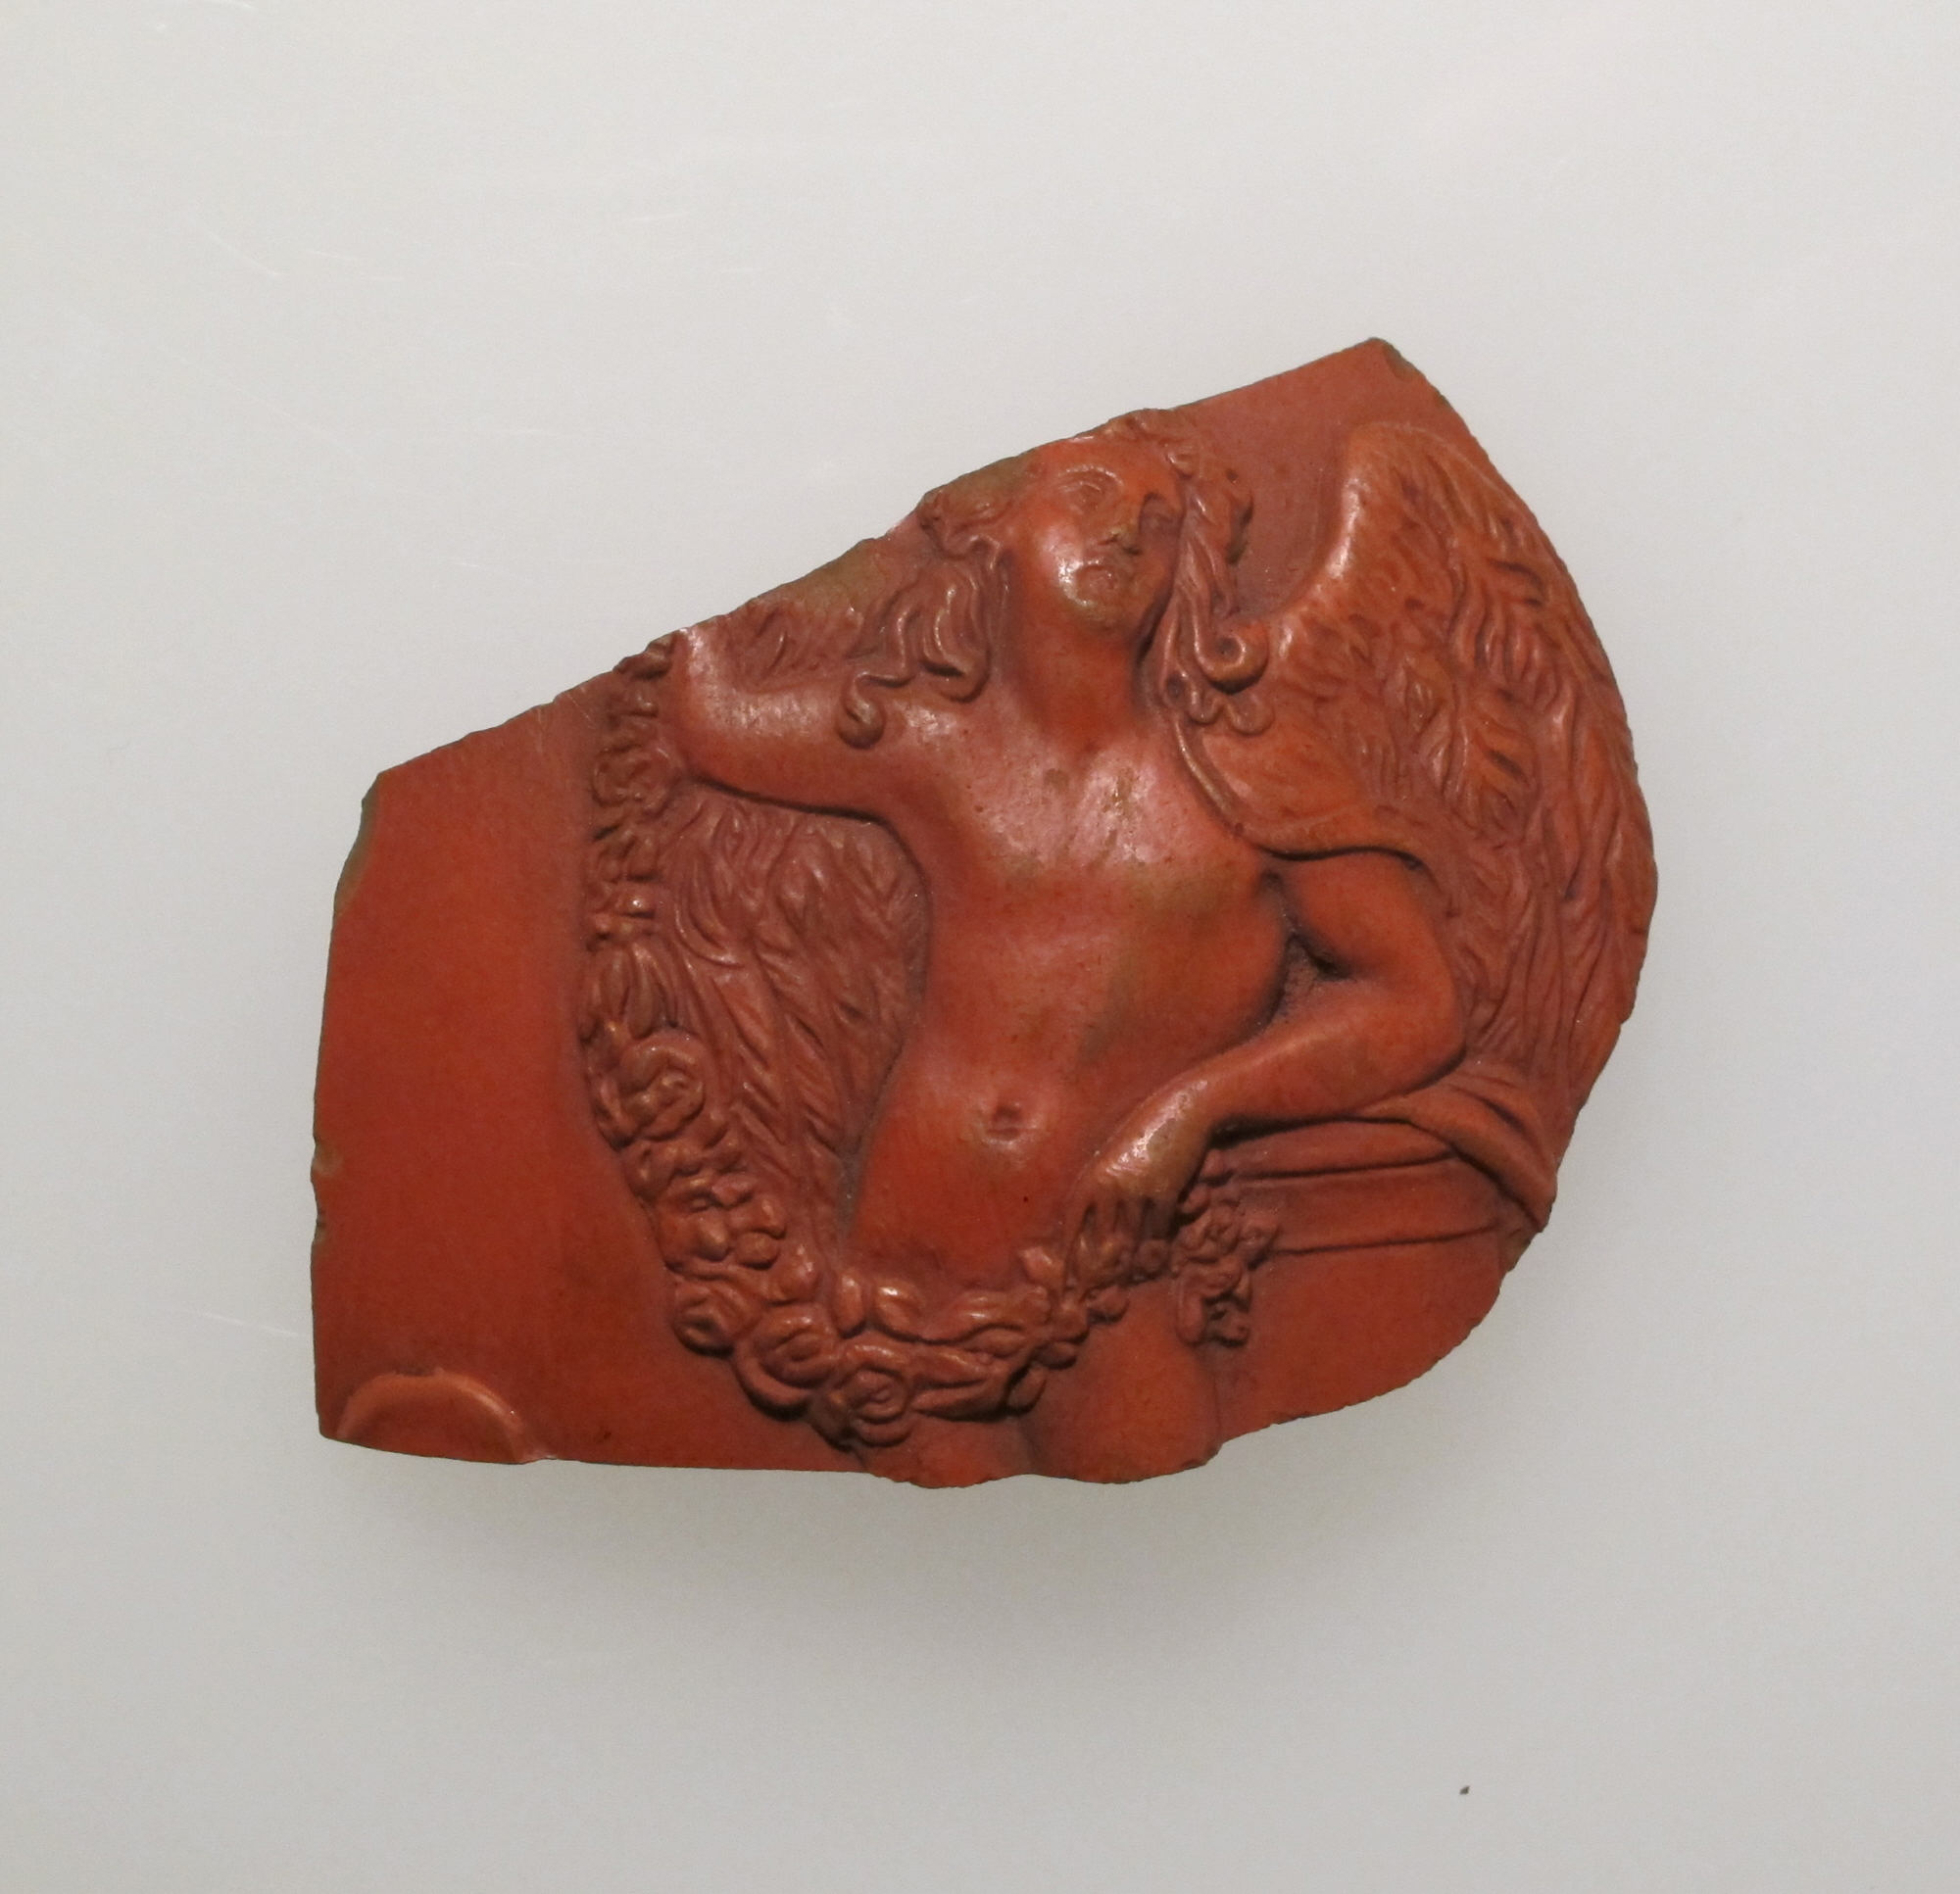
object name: vase fragment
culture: roman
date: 100 BCE-100 CE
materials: terracotta